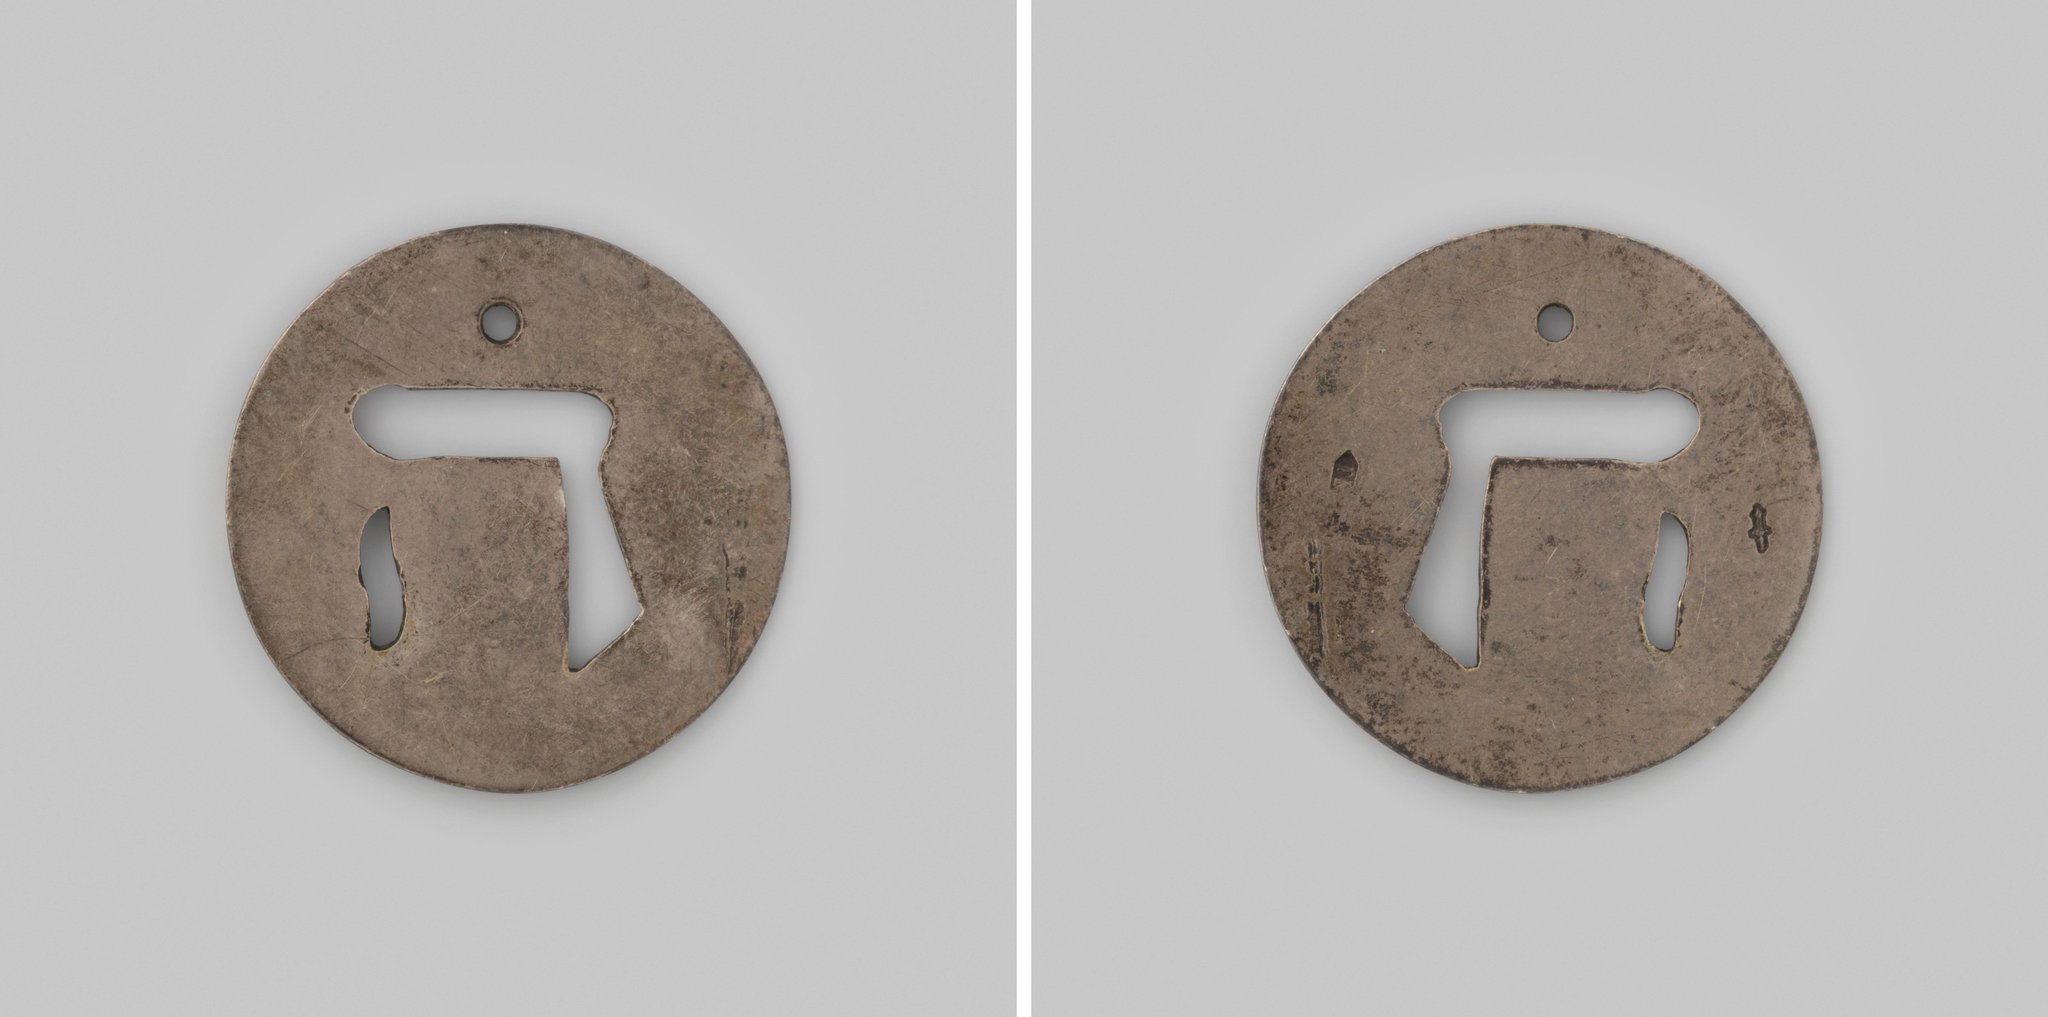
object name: history medal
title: Hei-amulet, 19e eeuw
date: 1800-1900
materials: silver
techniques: rolling, sawing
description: Zilveren plaatje met uitgezaagde Hebreeuwse leter hei en draaggat, op de keerzijde ingeslagen meester- en waarborgtekens.